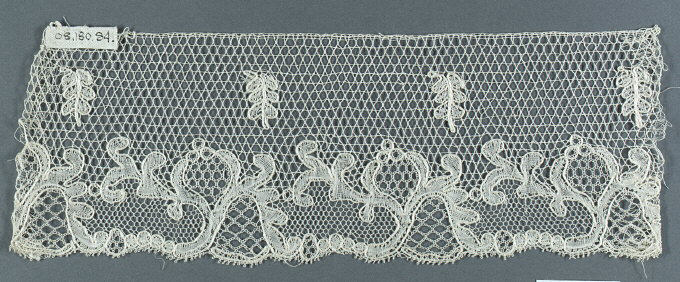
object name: fragment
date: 1801-1900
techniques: lace